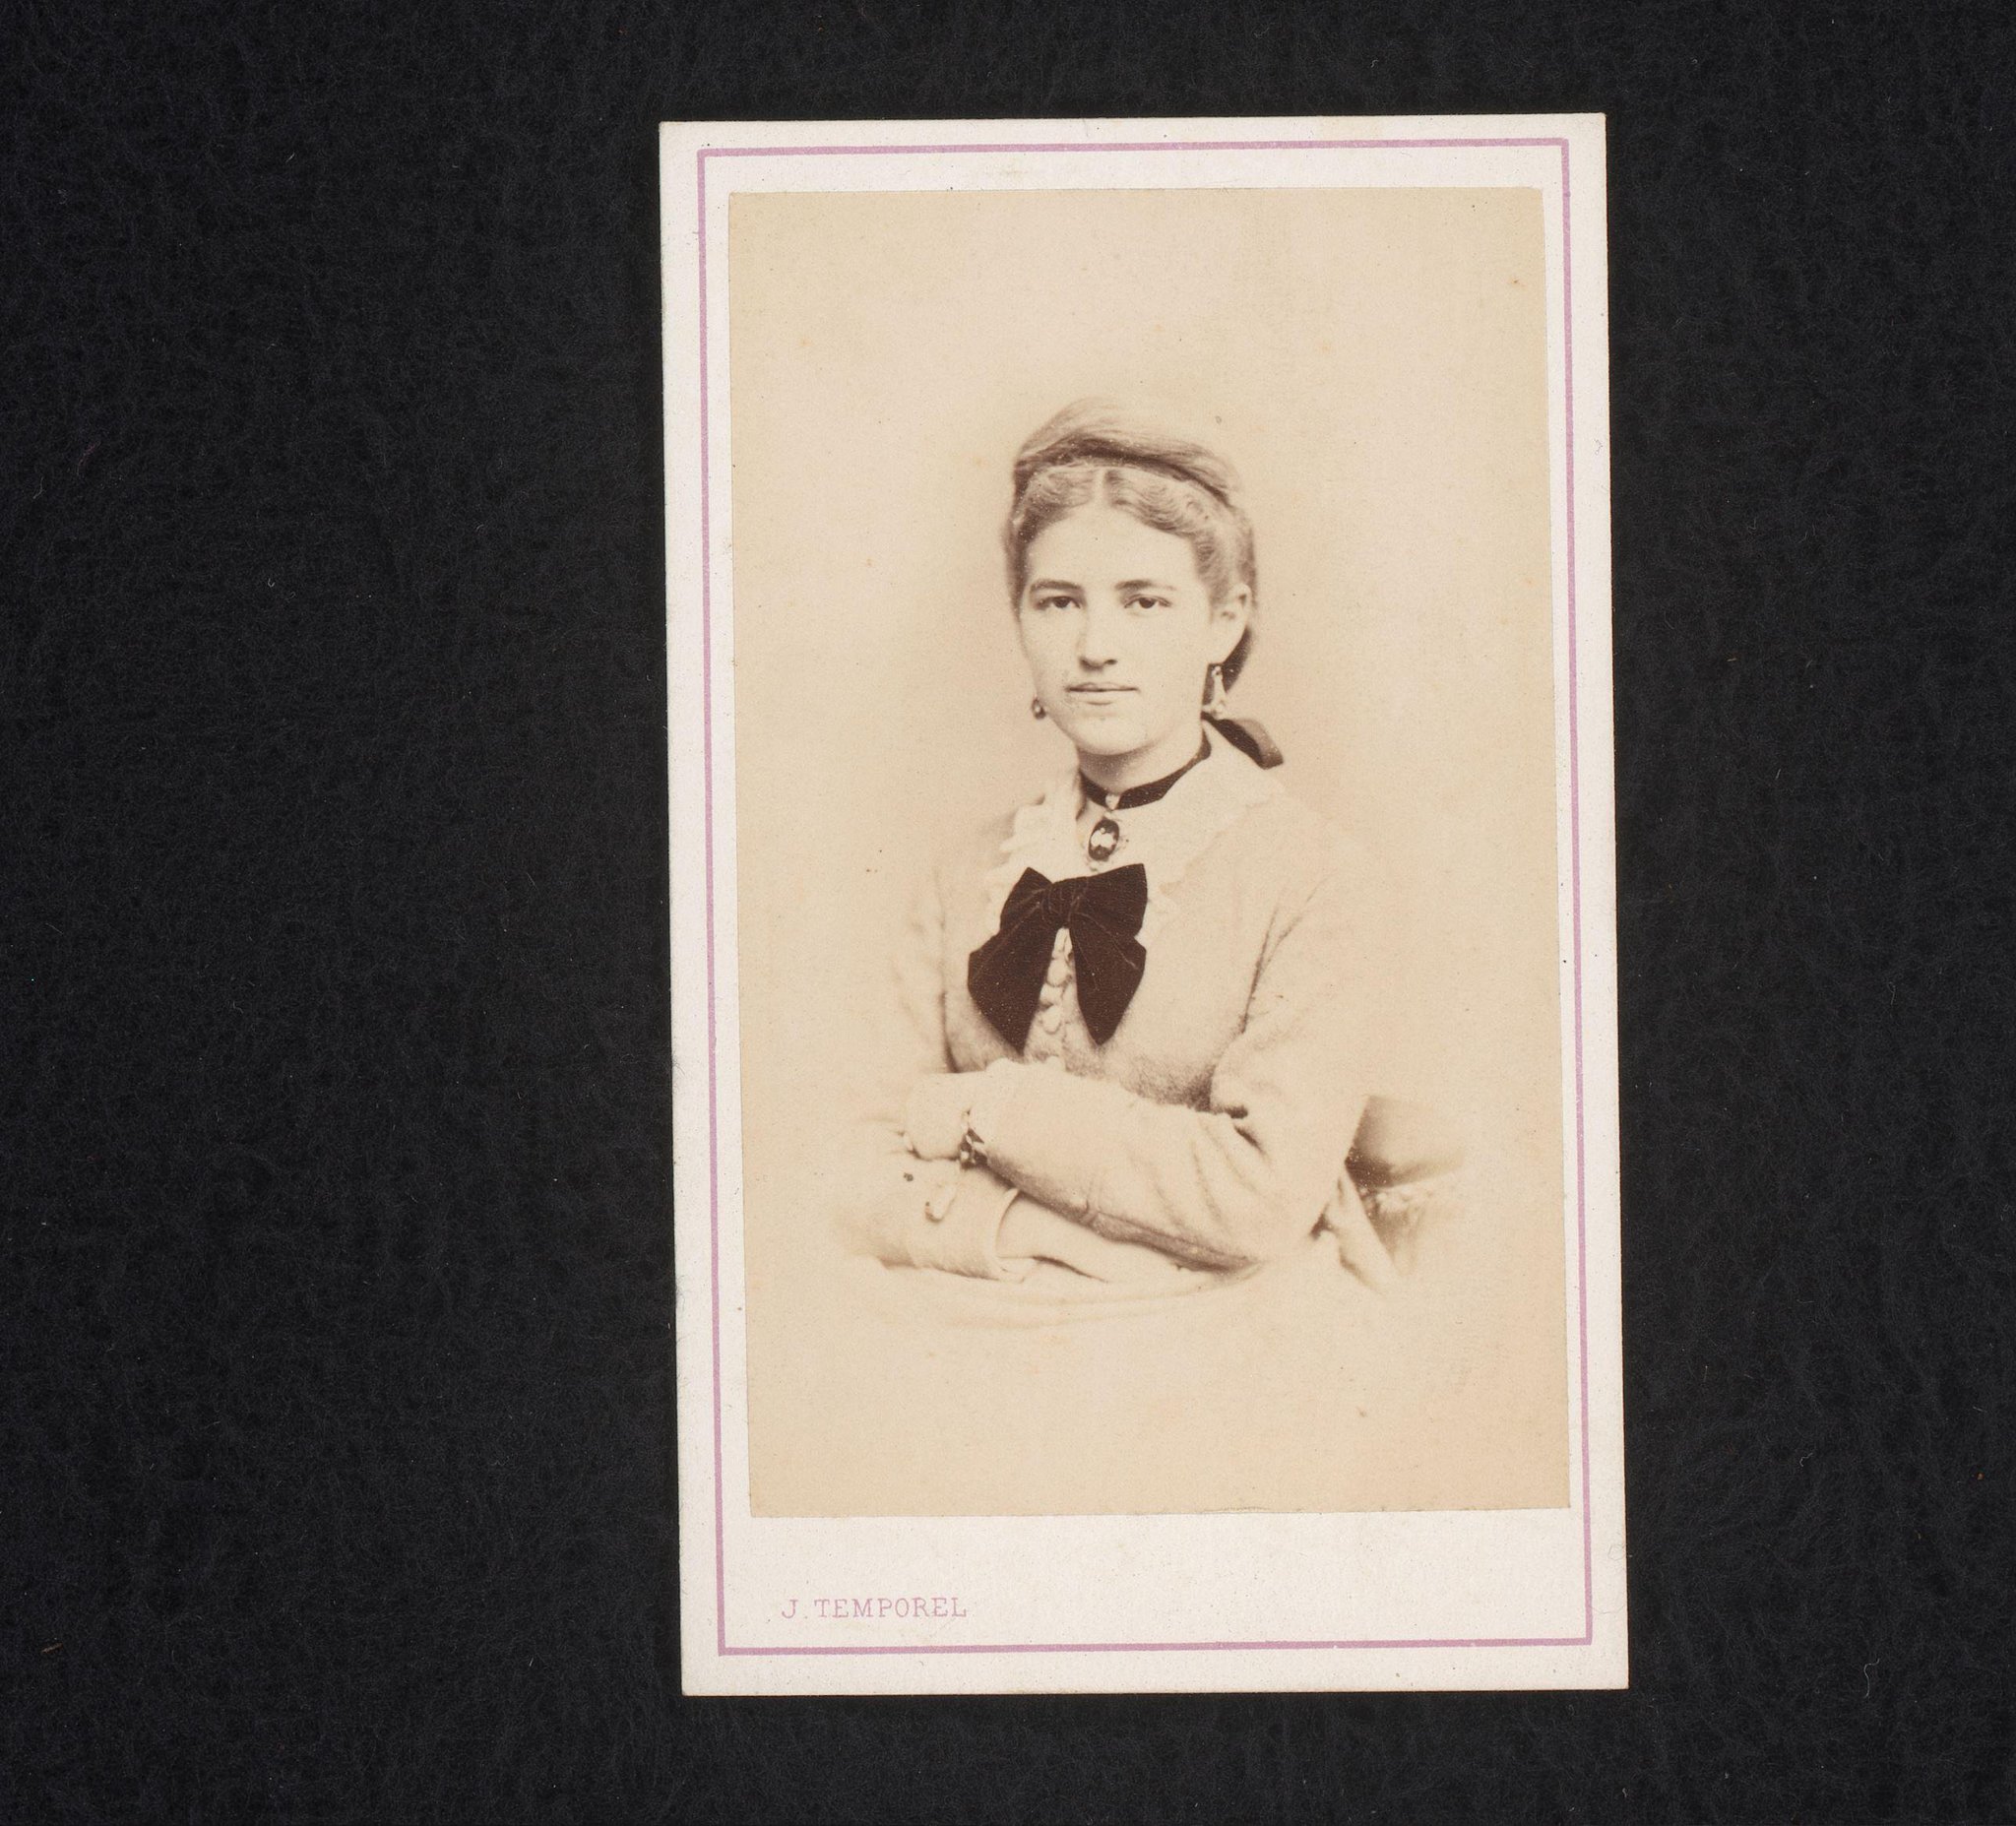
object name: carte de visite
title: Portret van een jonge vrouw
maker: j. temporel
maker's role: fotograaf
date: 1860-1890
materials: cardboard, photographic support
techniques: albumen print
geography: geneva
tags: adolescent, young woman, maiden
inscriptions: inscription: ‘J. Temporel/ Chemin Dancet & Rue Masbou/ Plainpalais/ Genève’